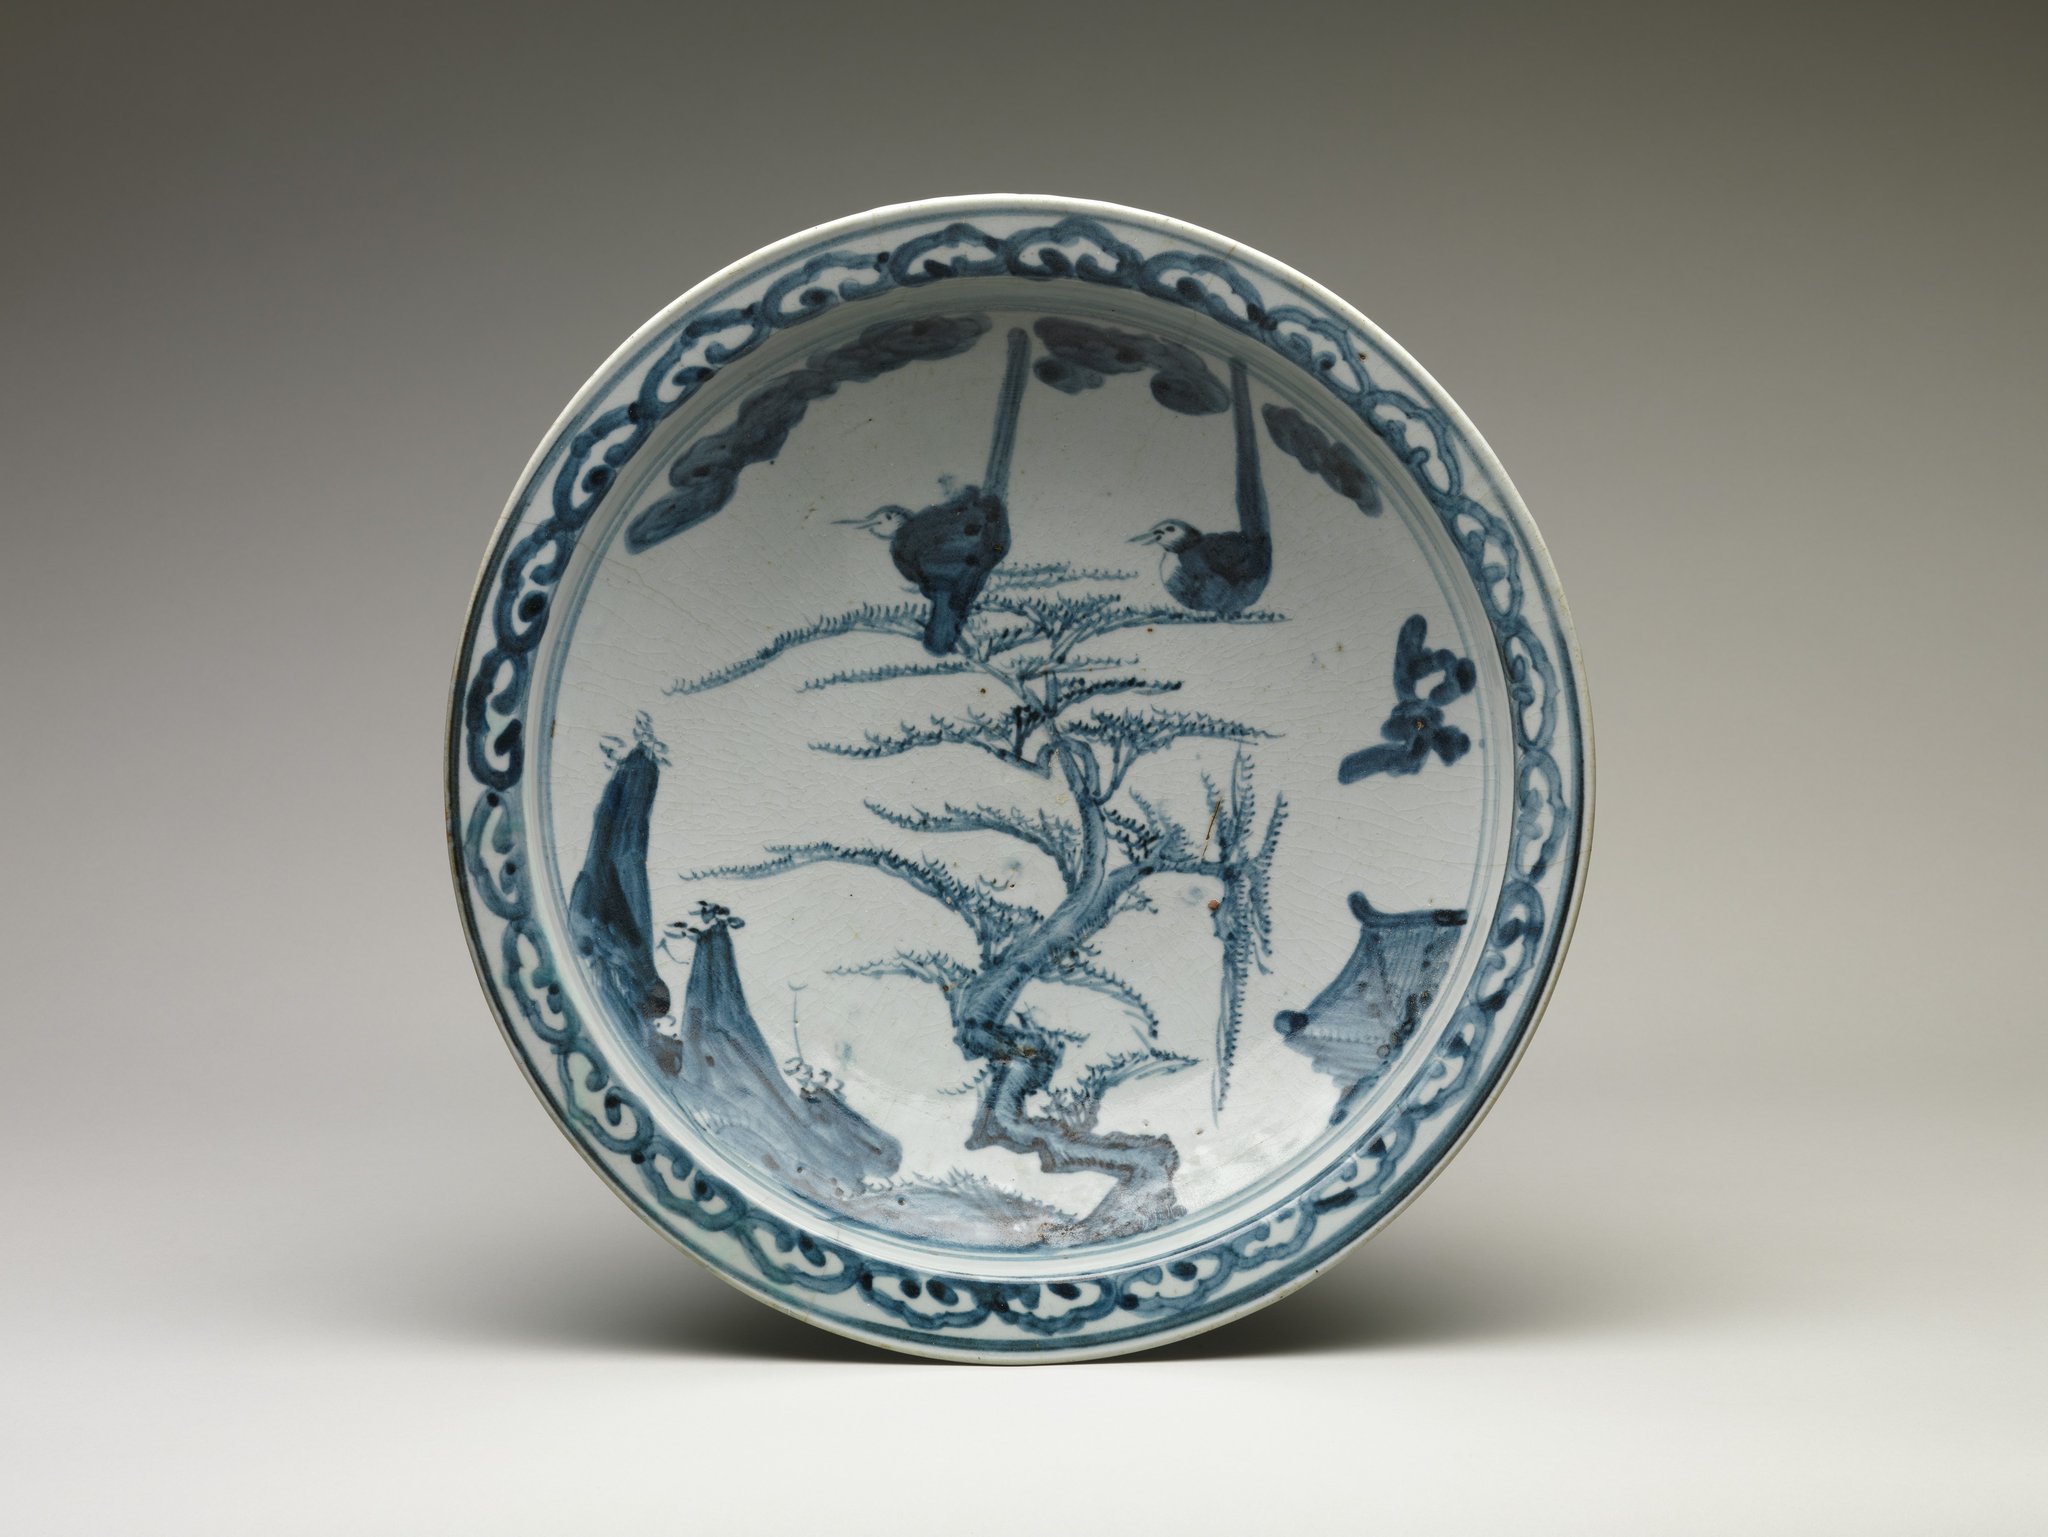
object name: dish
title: Dish with Birds on a Pine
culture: japanese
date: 1624-1643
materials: porcelain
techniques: underglaze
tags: birds,trees